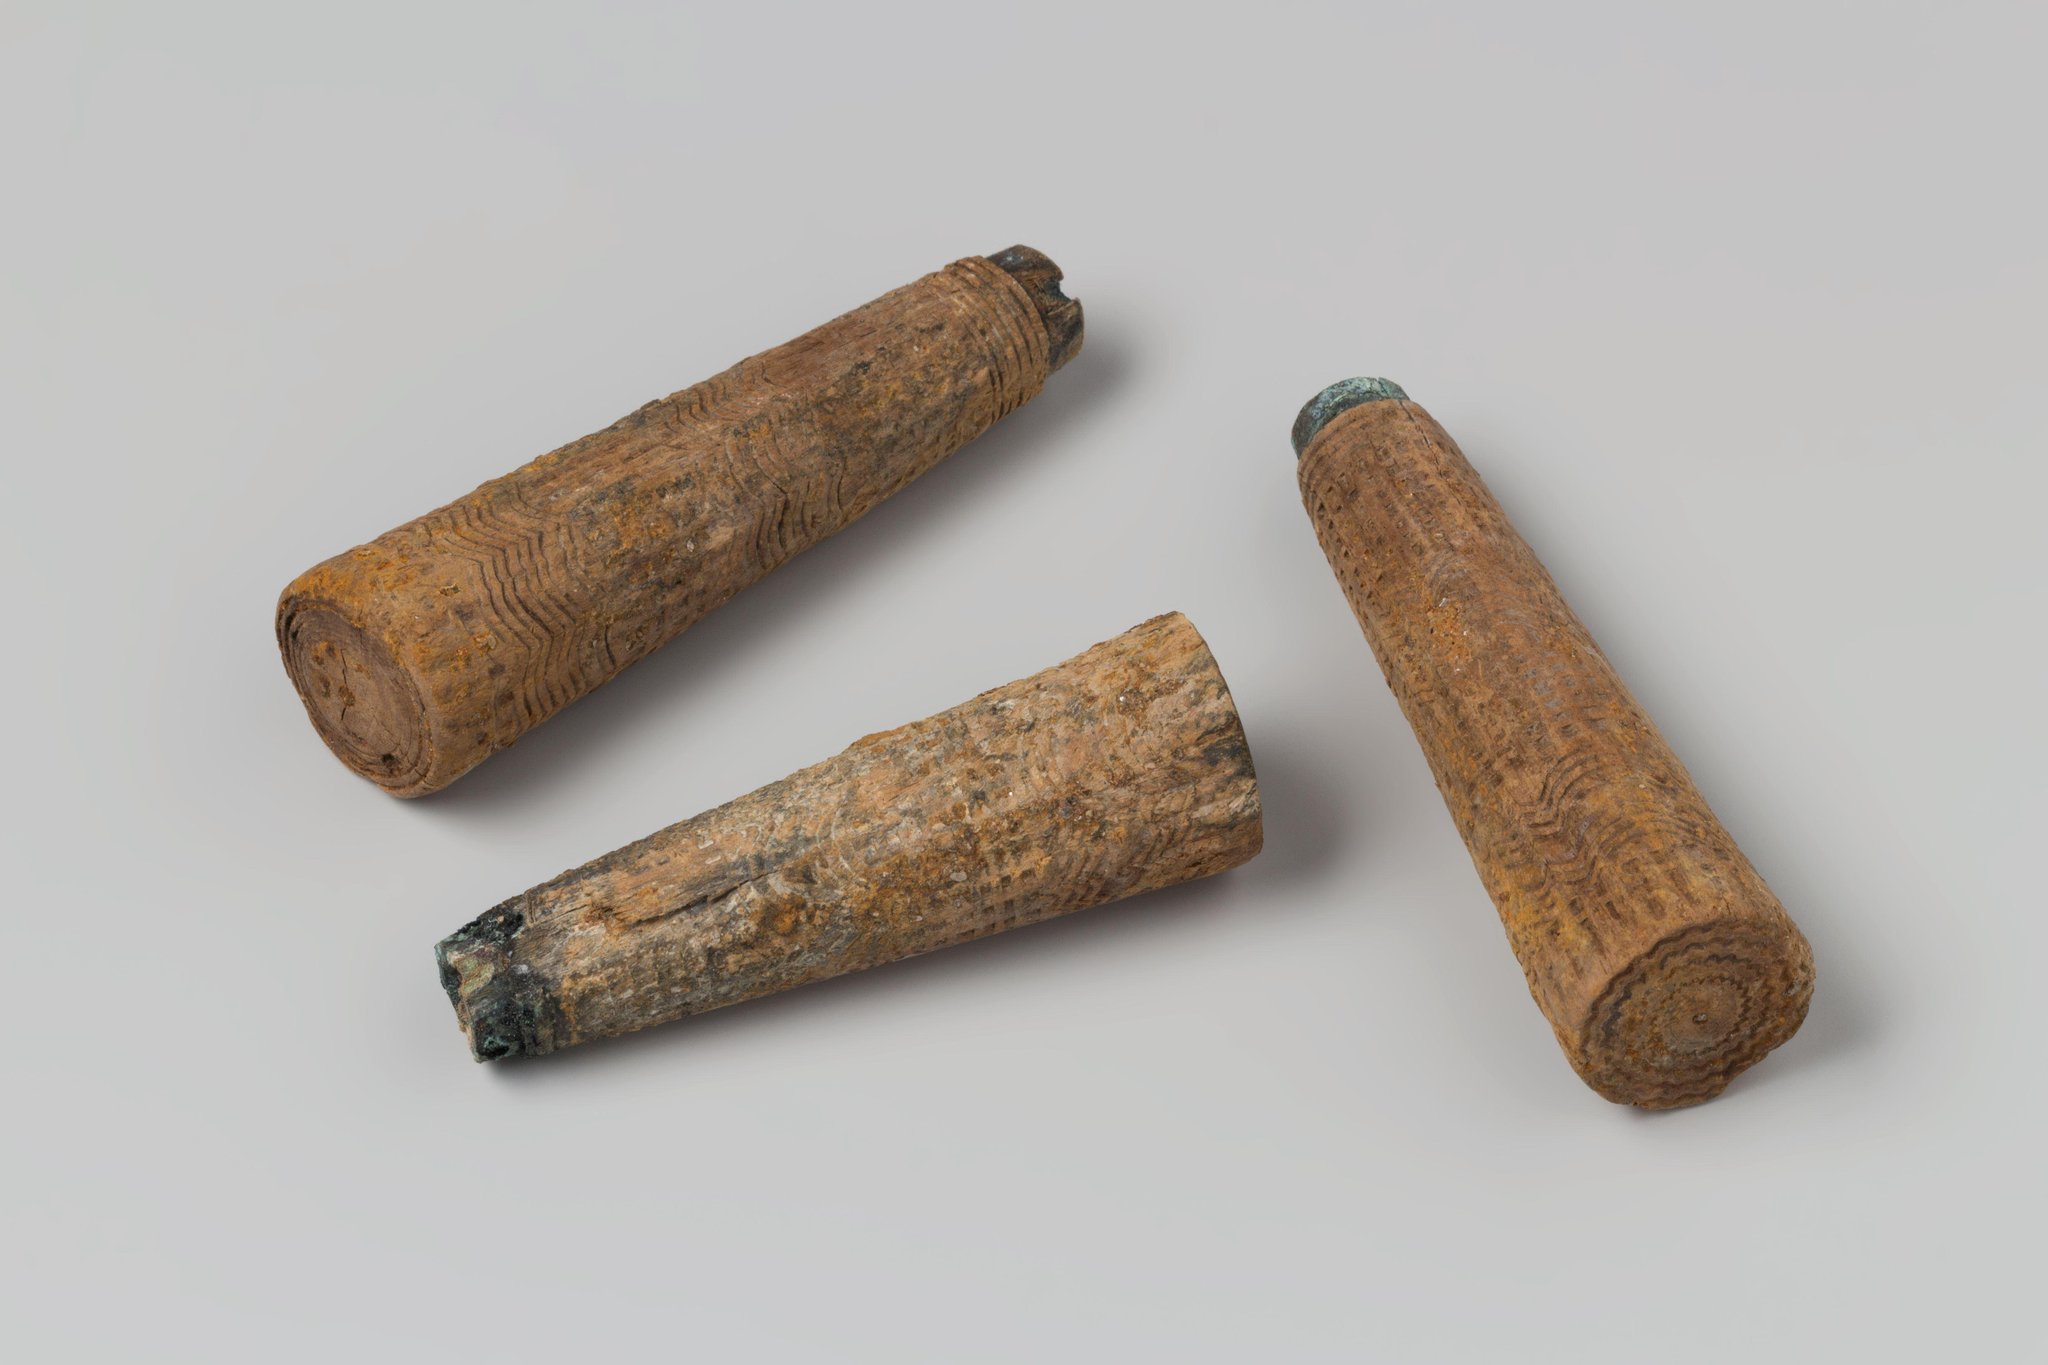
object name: knife handle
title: Messenheften uit het wrak van de Oost-Indiëvaarder Hollandia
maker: Anonymous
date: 1700-1743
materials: copper, wood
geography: netherlands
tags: verenigde oostindische compagnie, hollandia (schip), annet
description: Knife, handle, cylindrical: tapering; id. NG 1979-403H, ferrules, id. NG 1980-27H426.